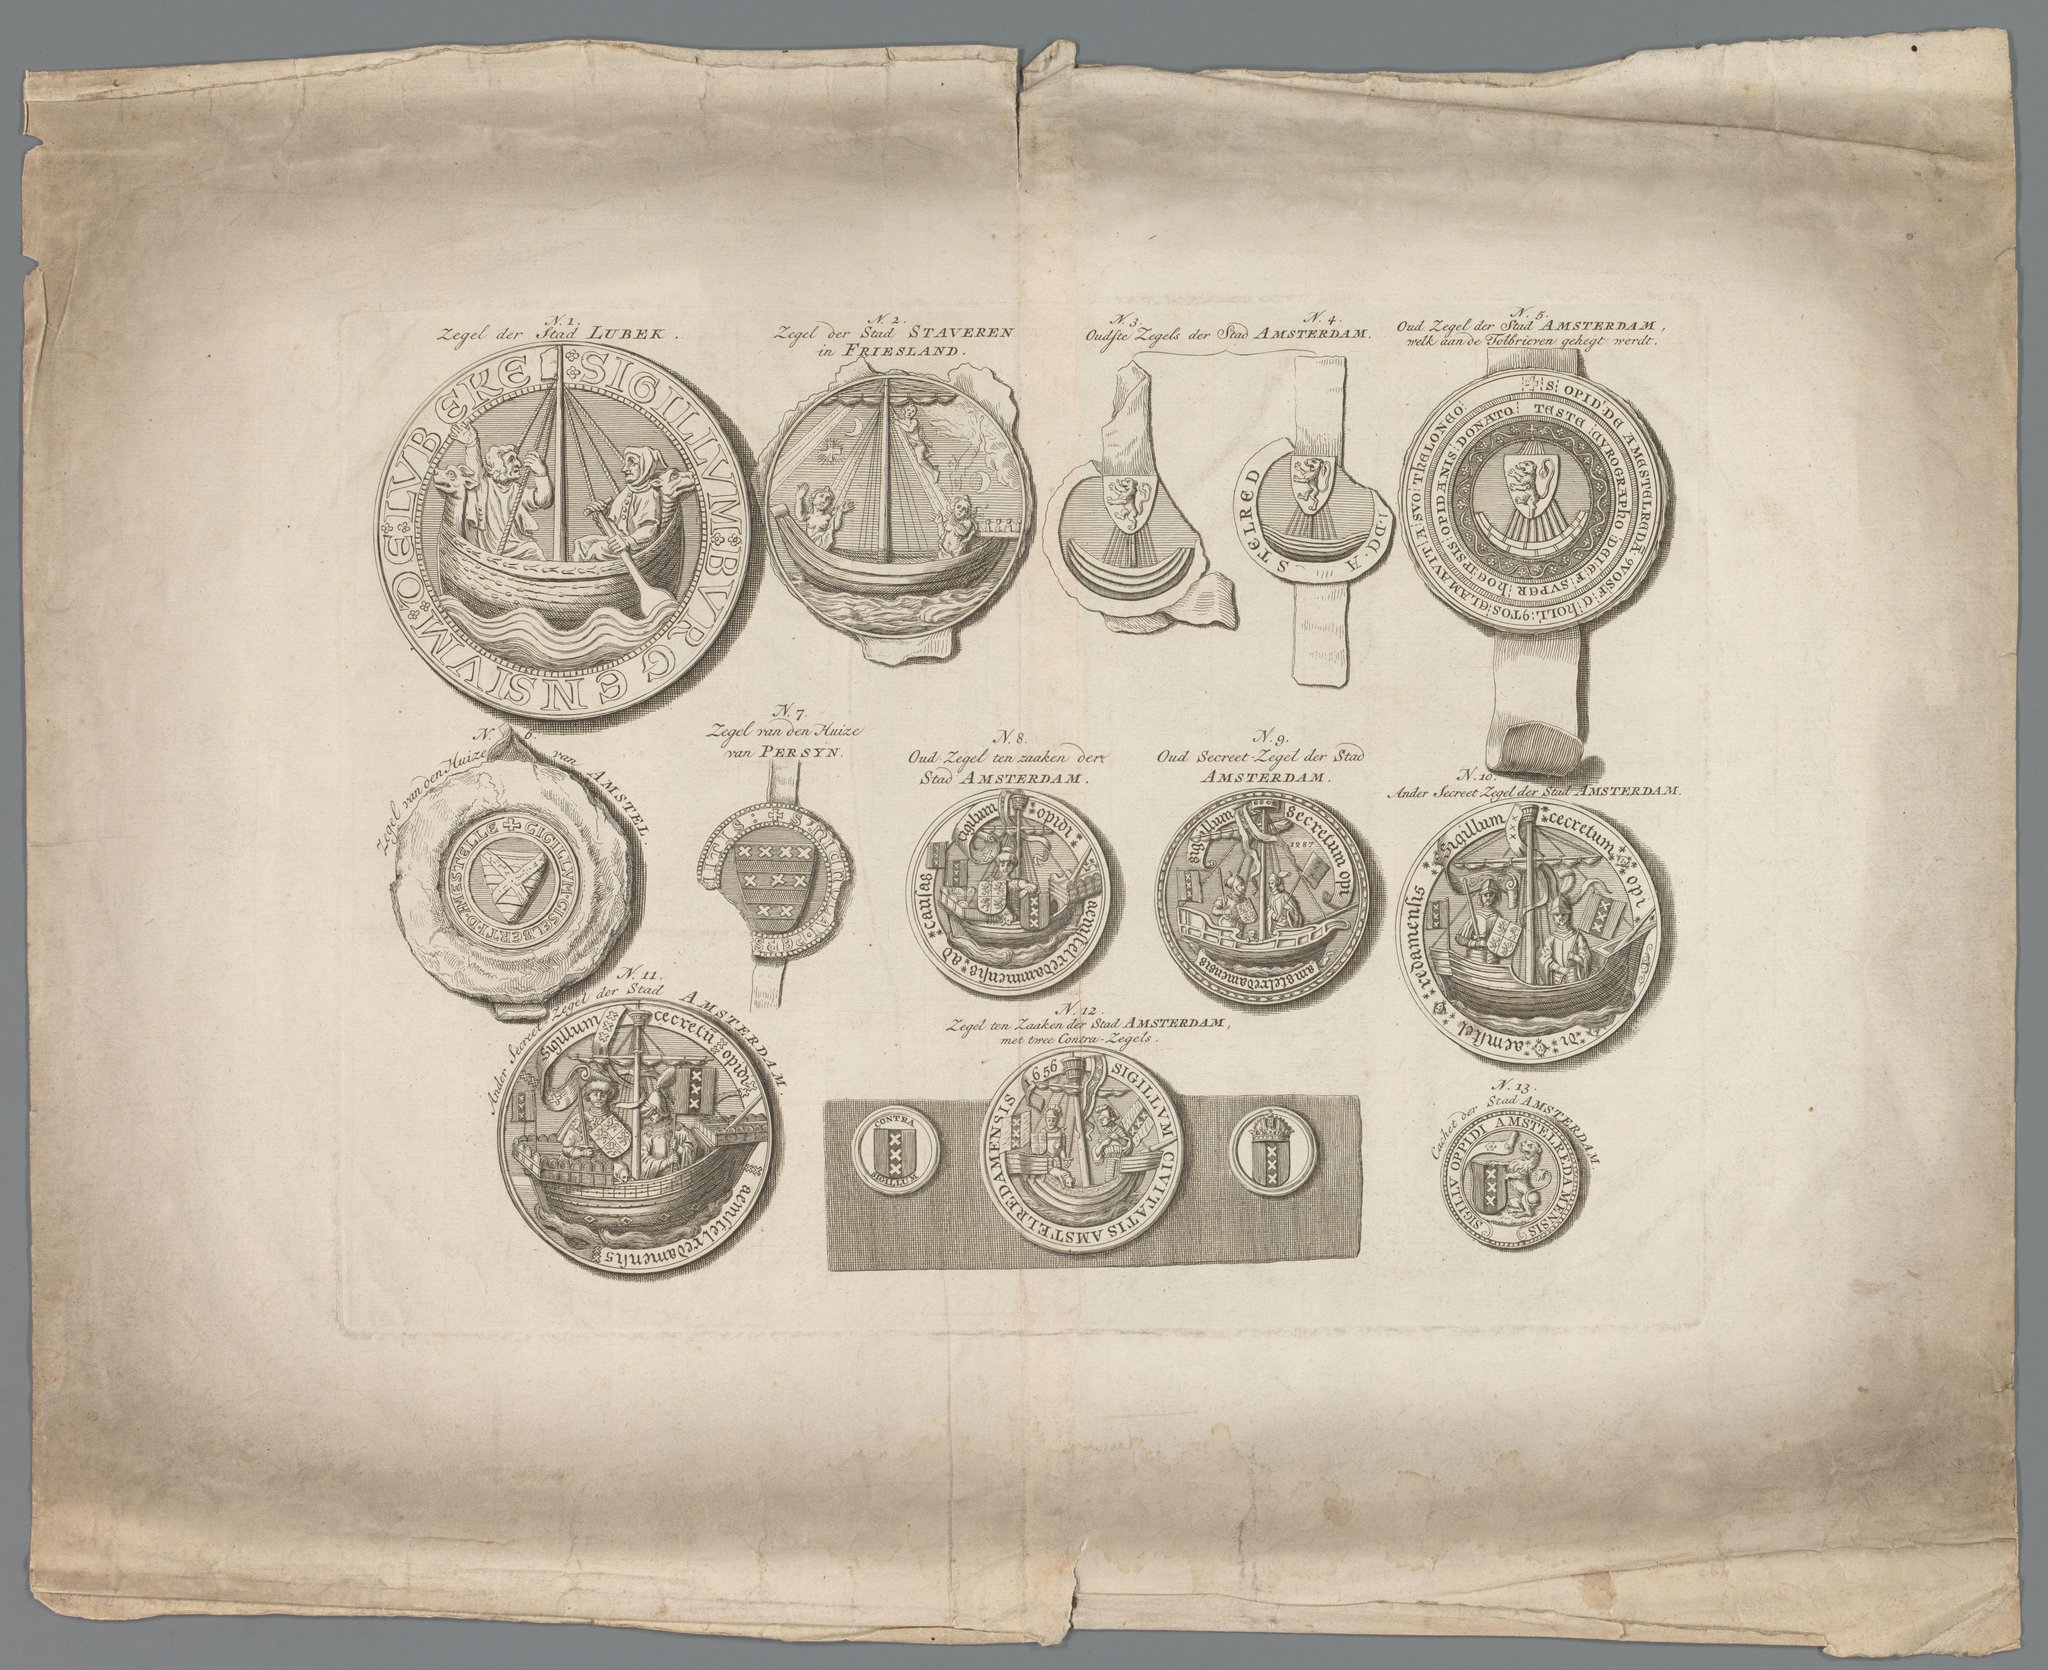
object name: print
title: Dertien zegels uit Amsterdam, Friesland en Lübeck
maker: Anonymous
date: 1767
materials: paper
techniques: engraving, etching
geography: amsterdam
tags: seal, stamp, armorial bearing, heraldry, amsterdam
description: Prent uit: Wagenaar, Jan. Amsterdam in zyne opkomst, aanwas en geschiedenissen (...). Amsterdam: Jacob Yntema en Jacob Tieboel, 1767, dl. 3. Prent mogelijk ook gebruikt in latere edities van dit werk.